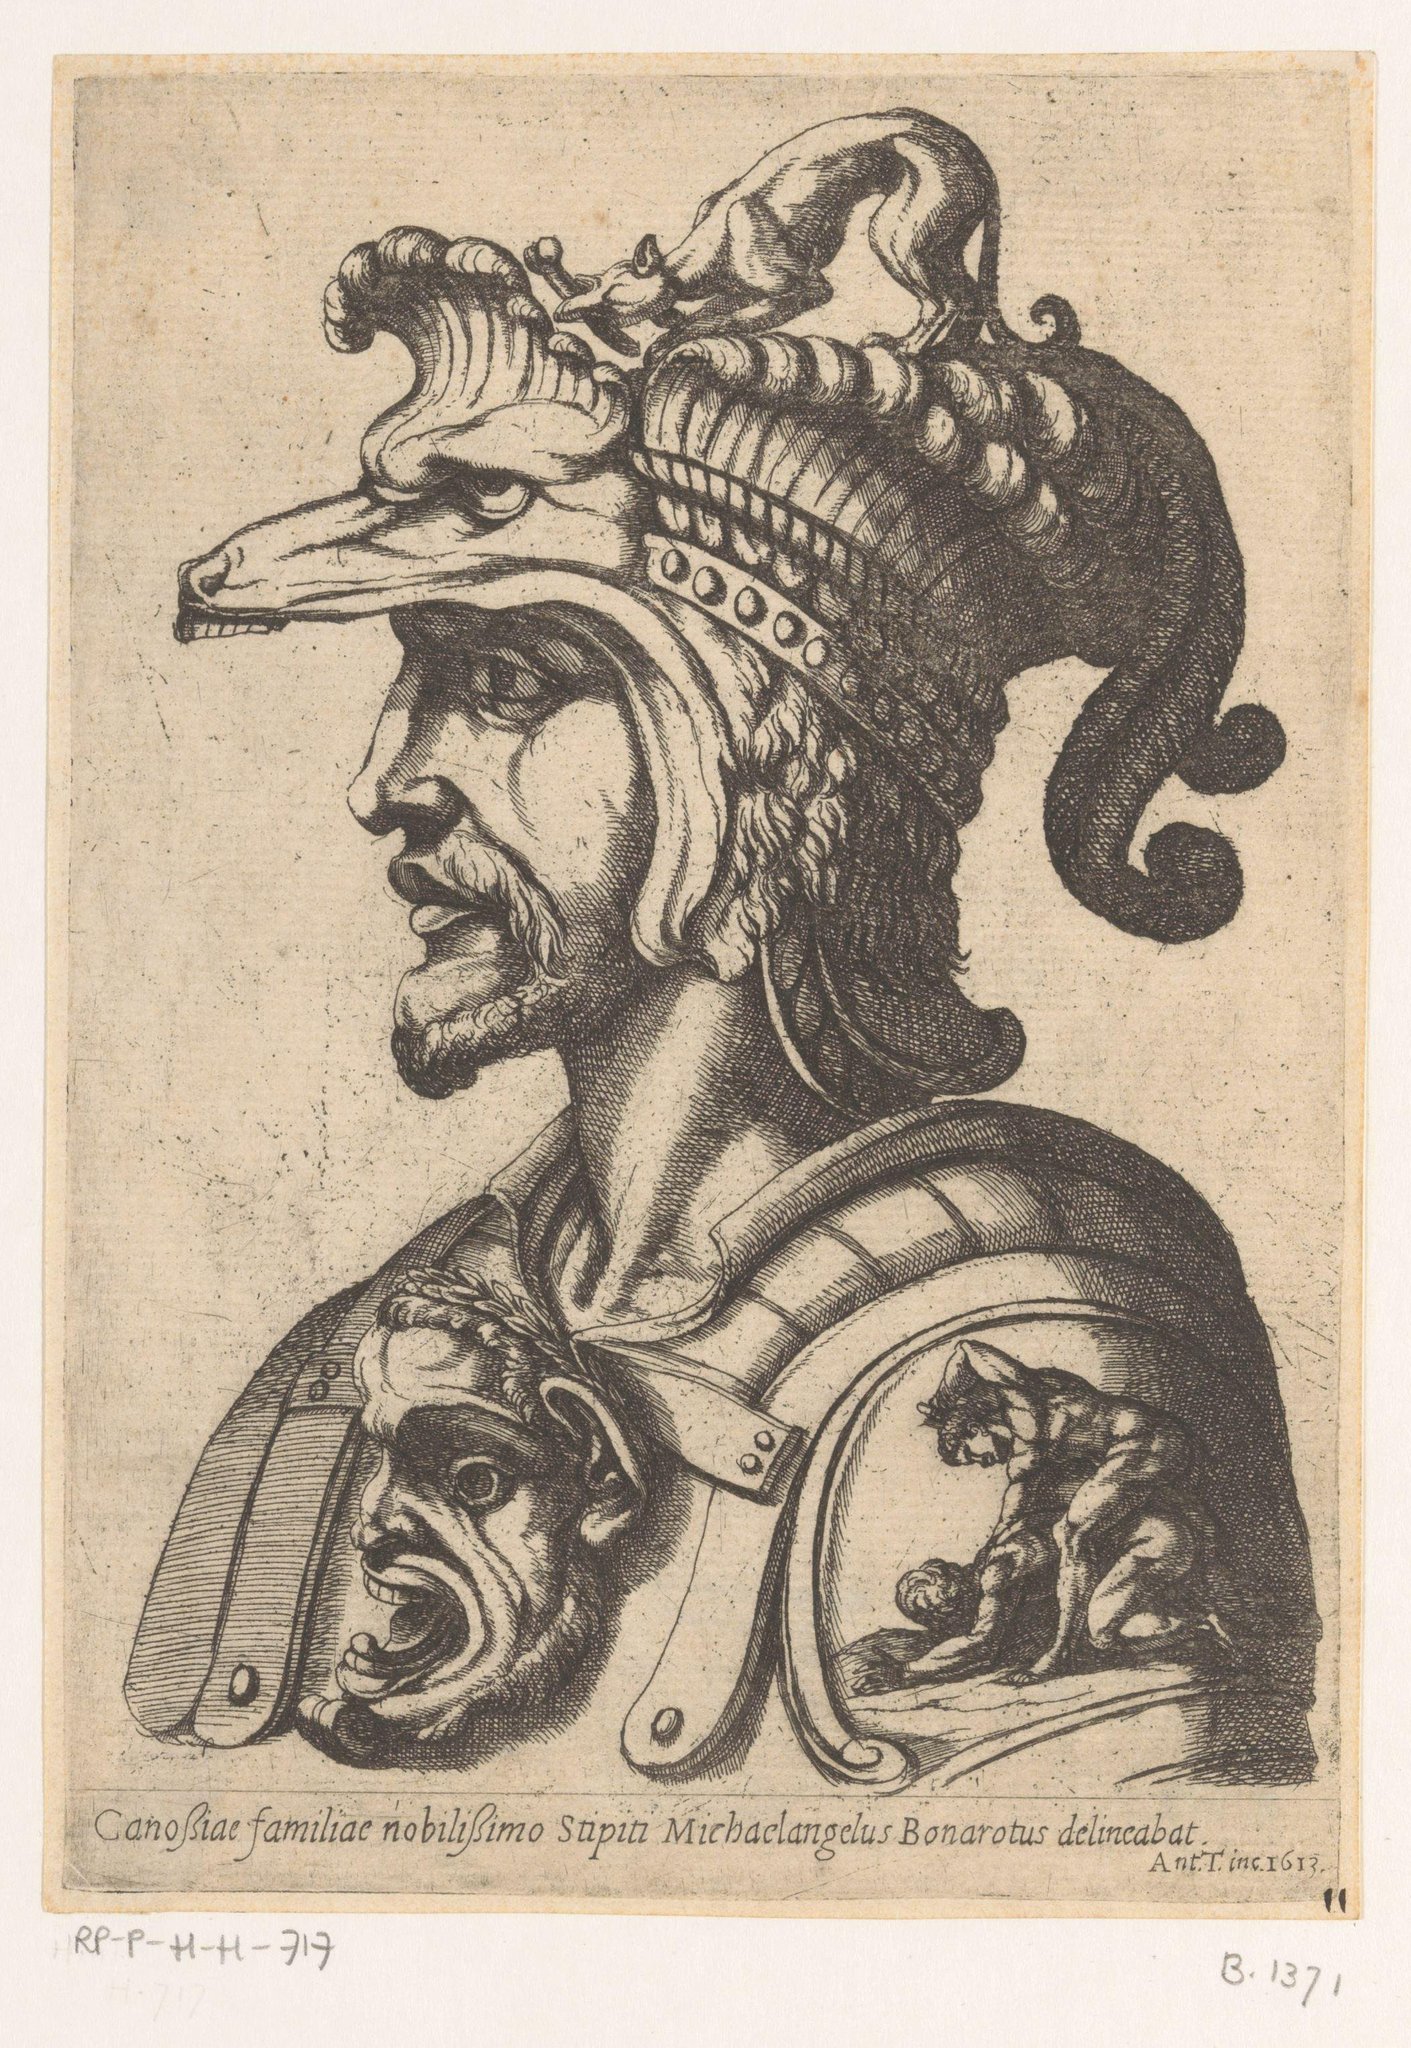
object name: print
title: Buste van man met helm, naar links gewend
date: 1613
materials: paper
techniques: etching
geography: italy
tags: helmet, abel's death, head (human) (+ sideview, profile)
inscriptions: collector's mark: Lugt 11, collector's mark: ‘Hinloopen’, number: ‘11’